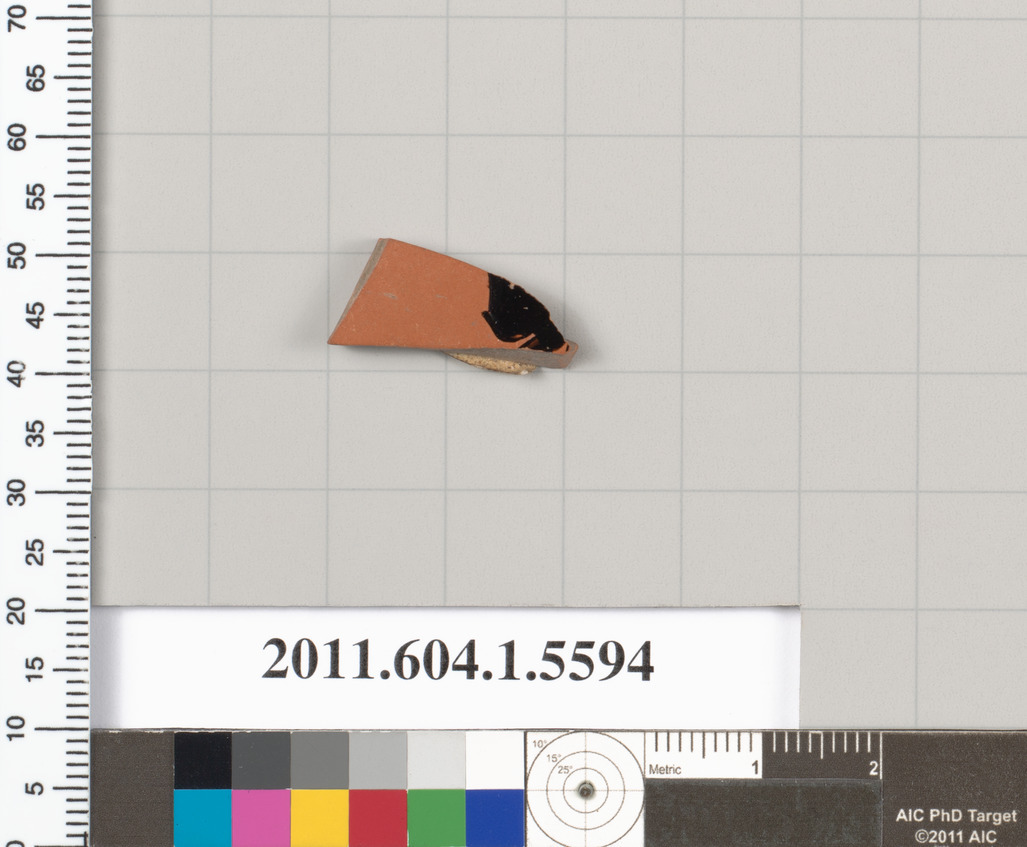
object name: kylix fragment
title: Terracotta rim fragment of a kylix (drinking cup)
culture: greek, attic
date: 500-480 BCE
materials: terracotta